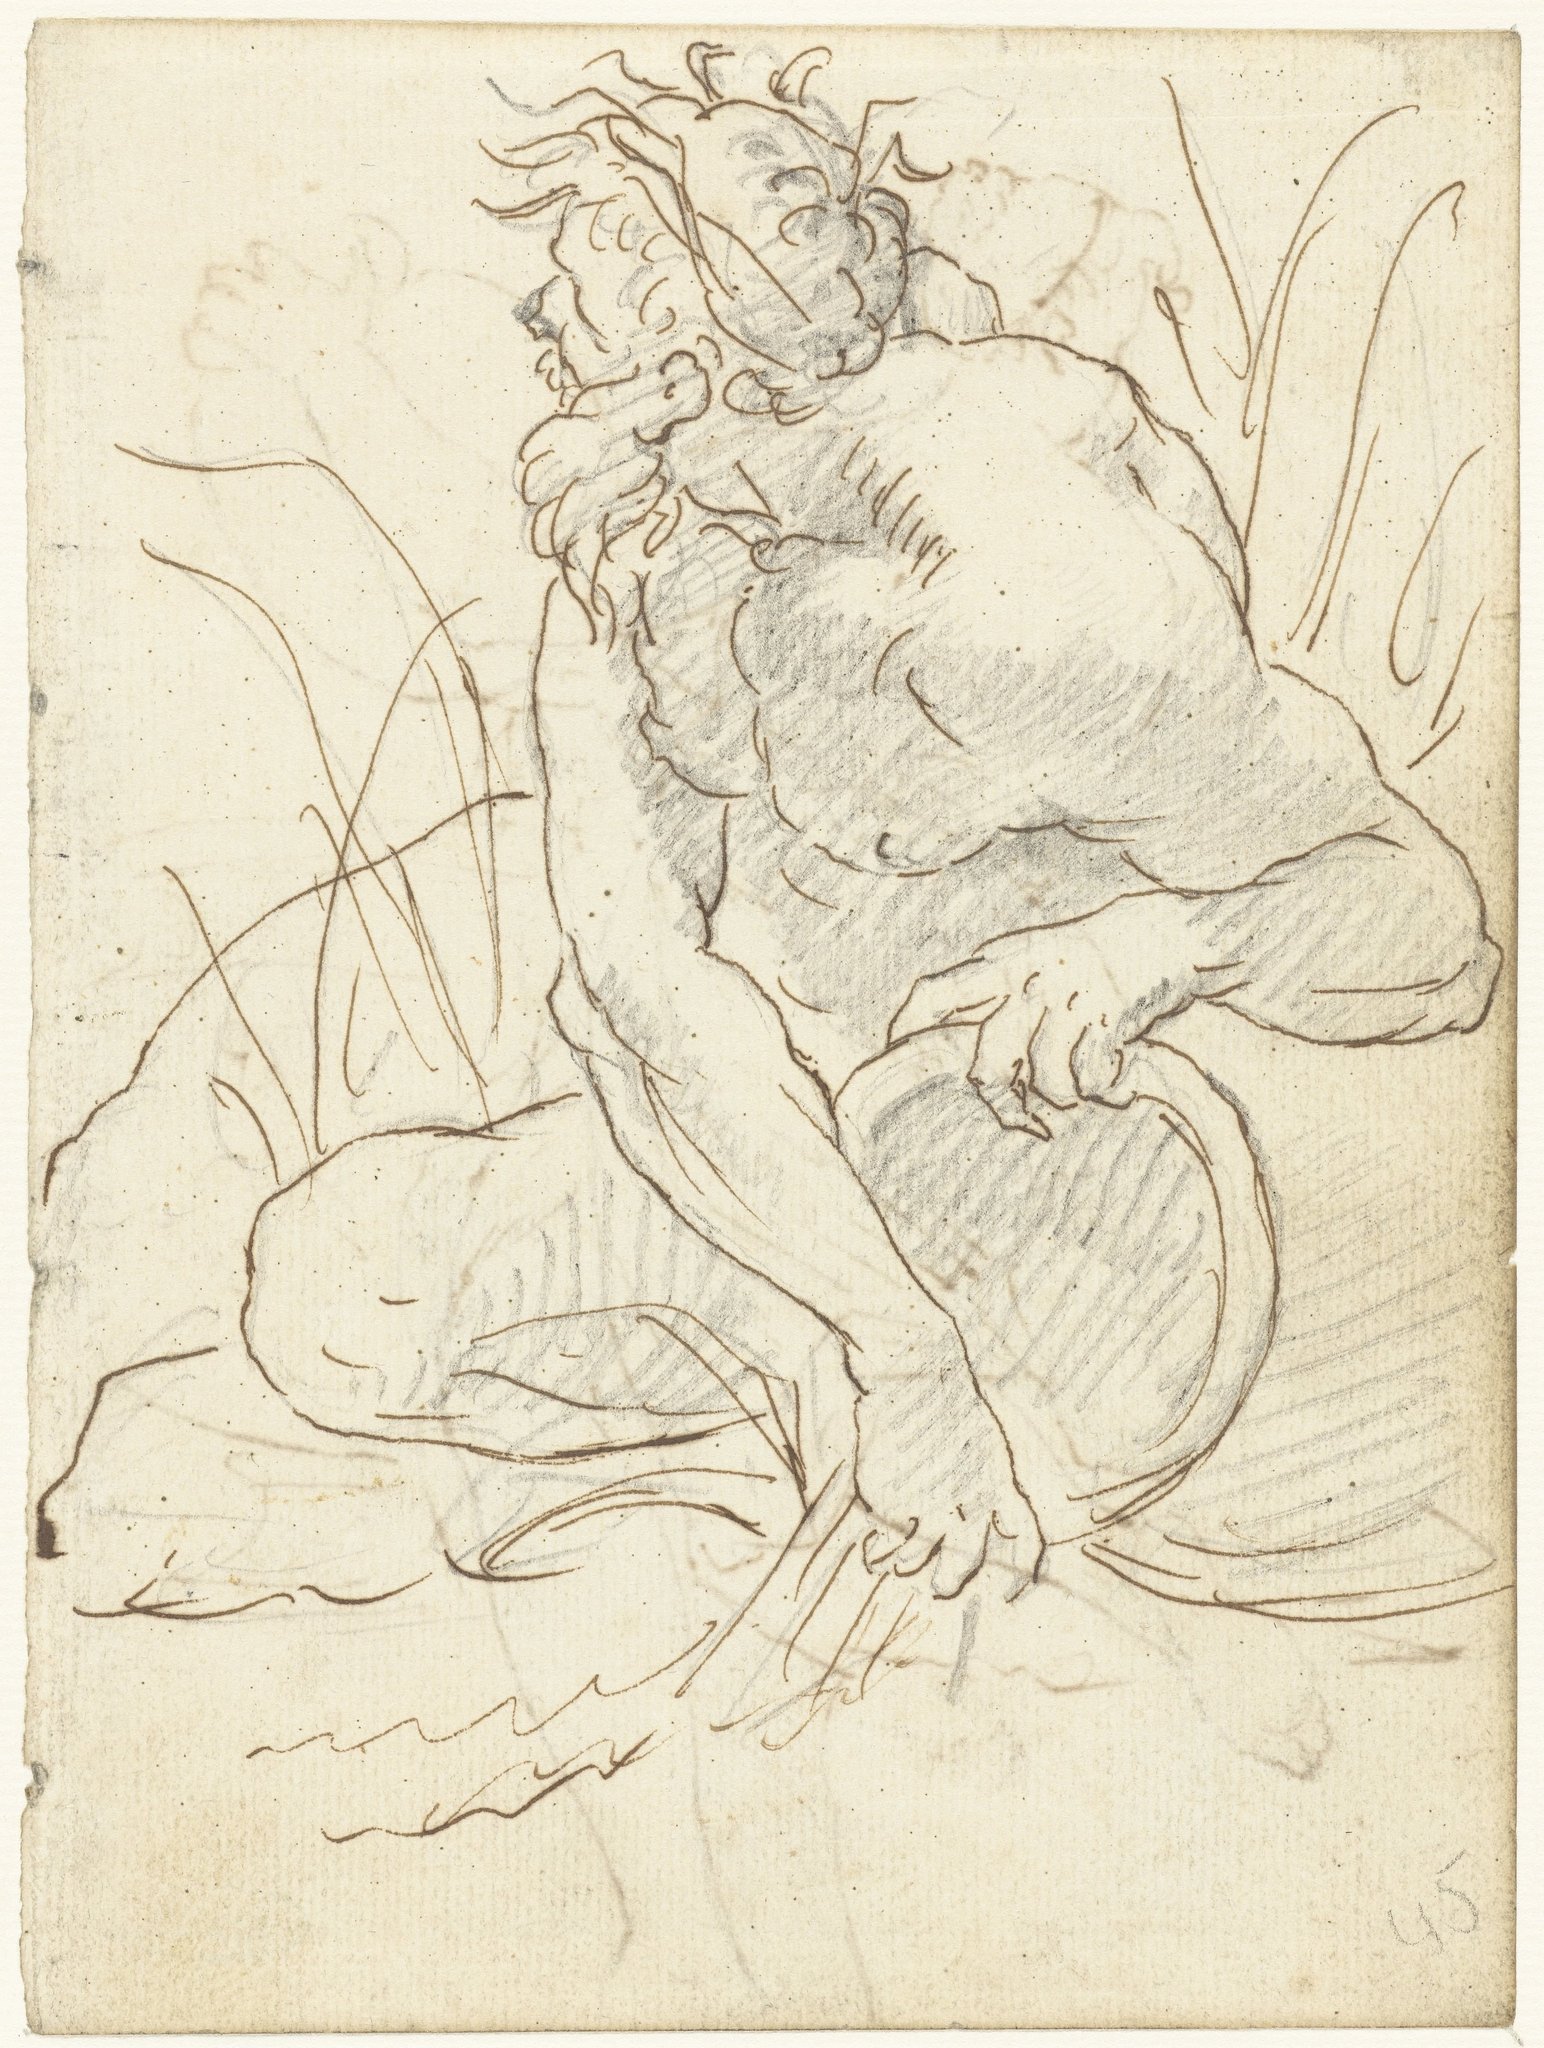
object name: drawing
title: Riviergod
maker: dionys van nijmegen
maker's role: draughtsman, painter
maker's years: 1705-1798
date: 1715-1798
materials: ink, paper, pencil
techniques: pen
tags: river personified, 'fiumi' (ripa)